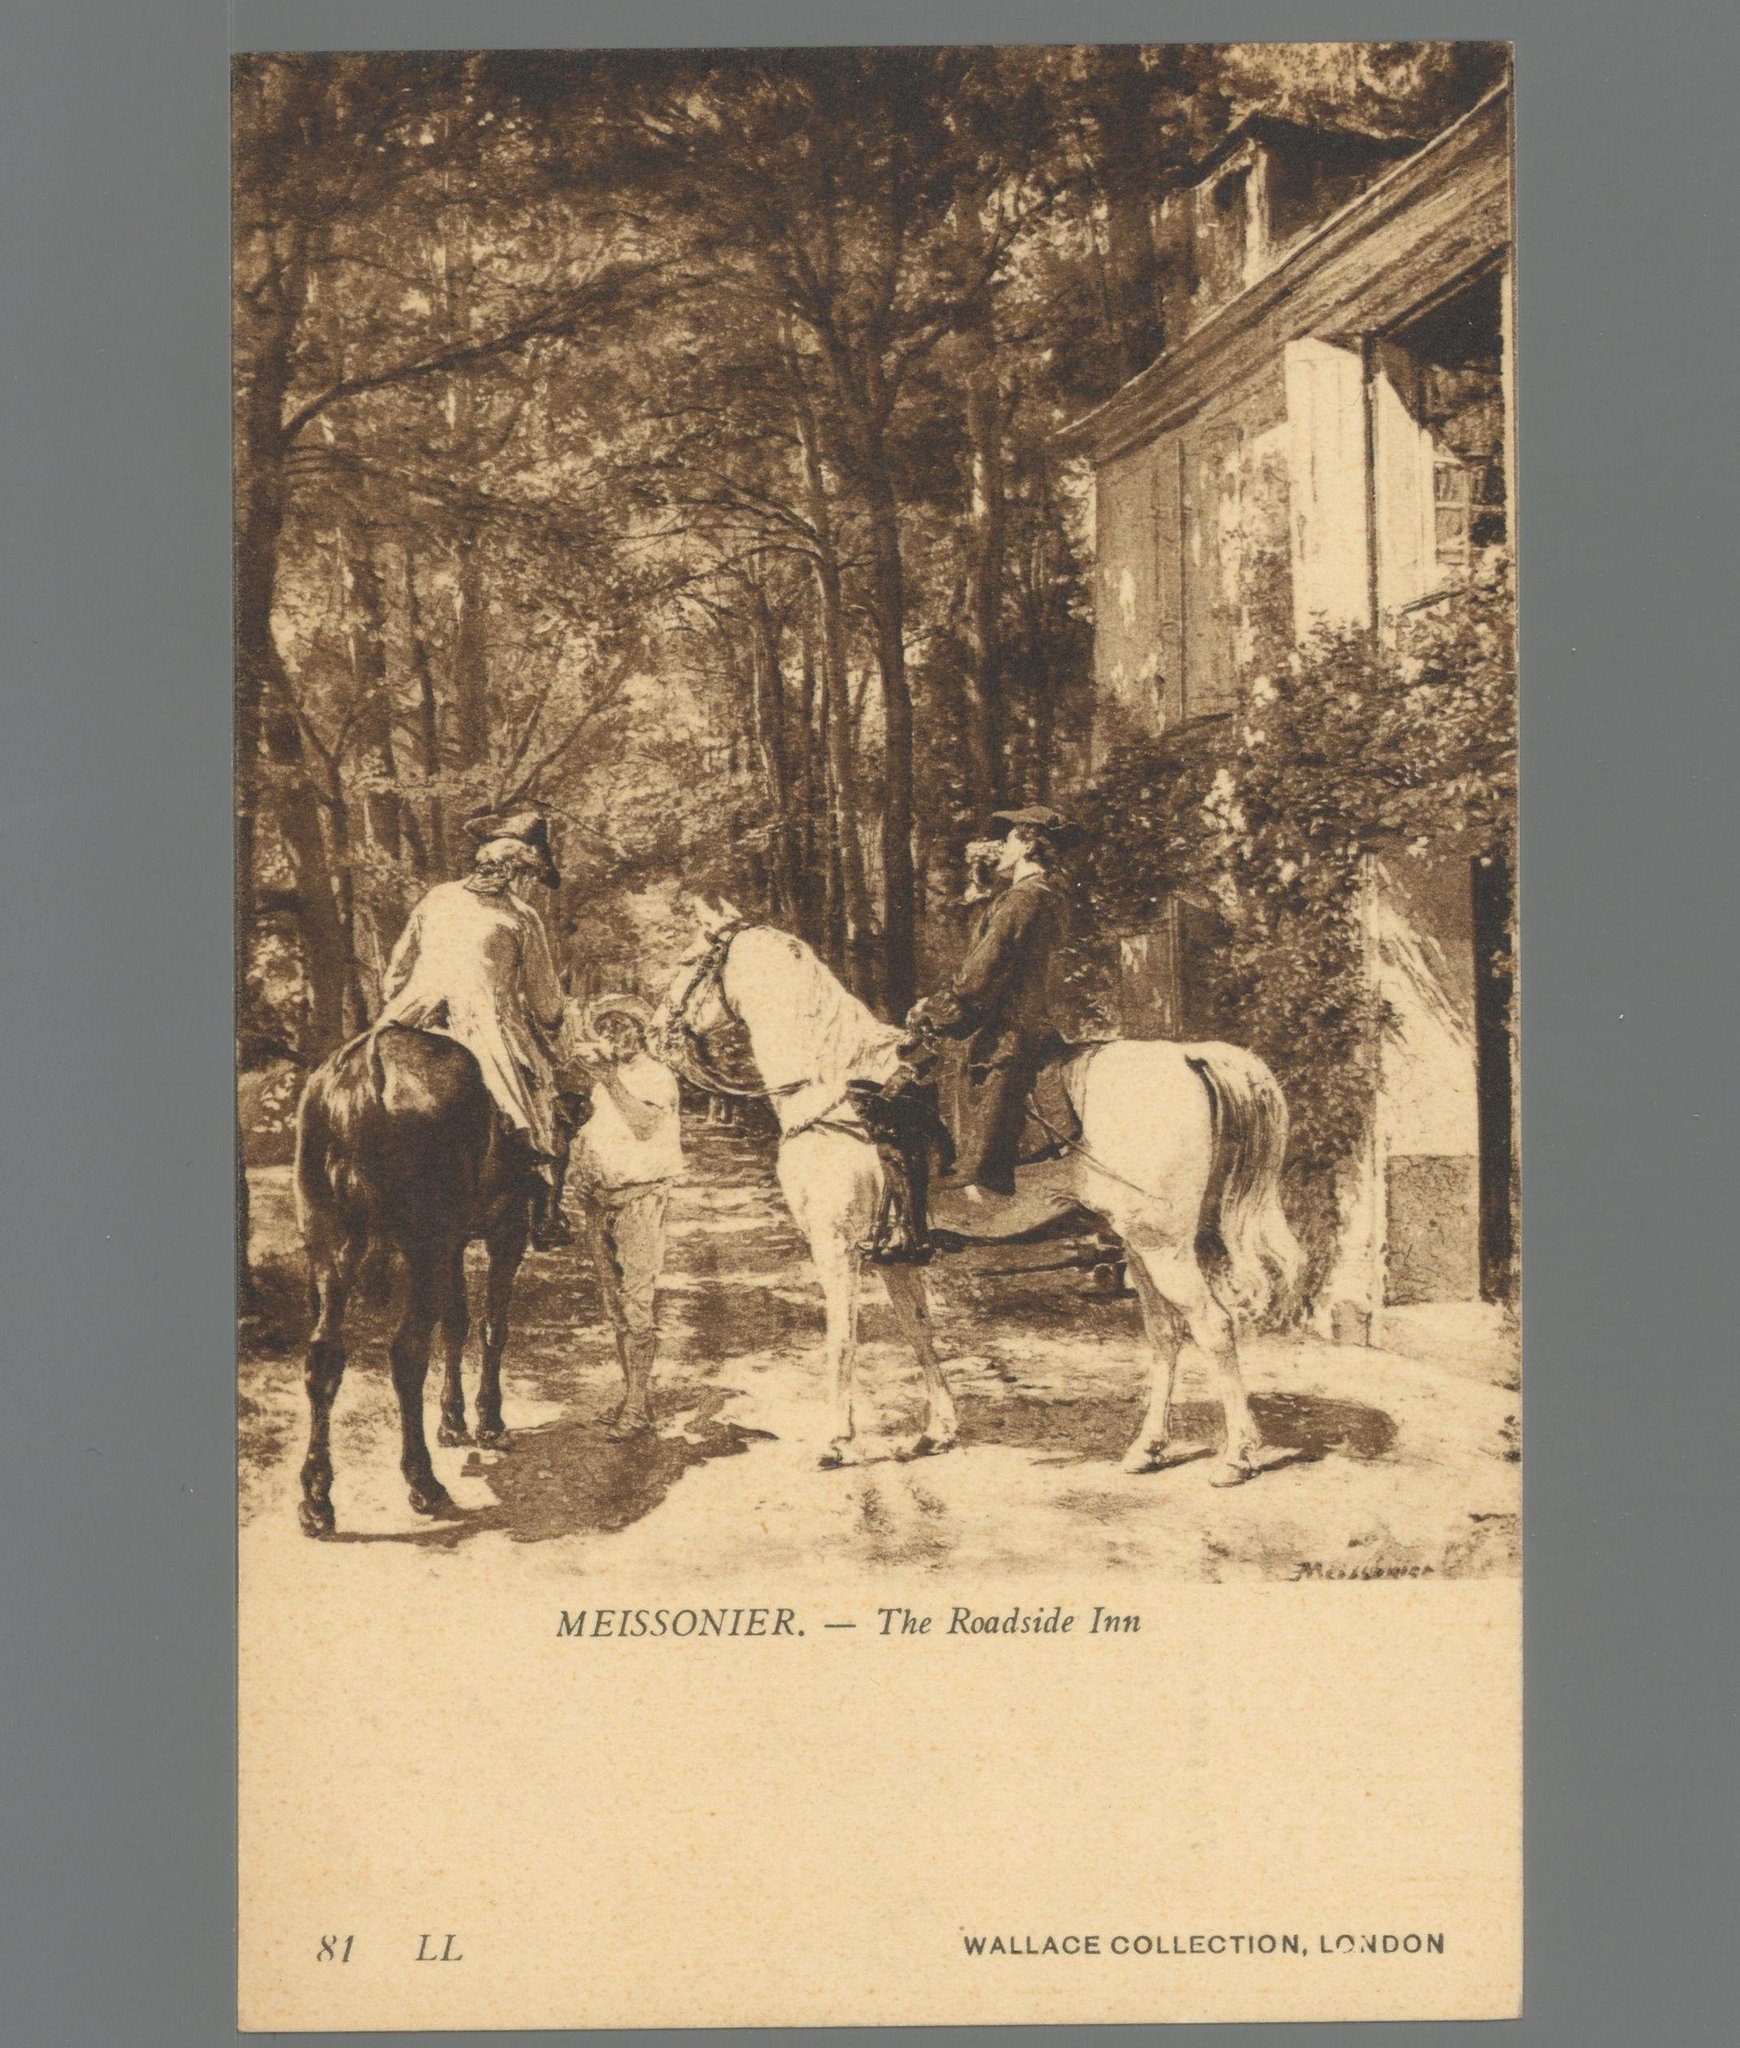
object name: reproduction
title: Meissonier - The Roadside Inn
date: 1902-1920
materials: cardboard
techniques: photograph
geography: paris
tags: permanent exhibition, museum, picture, painting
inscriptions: collector's mark: ‘AFE v S’